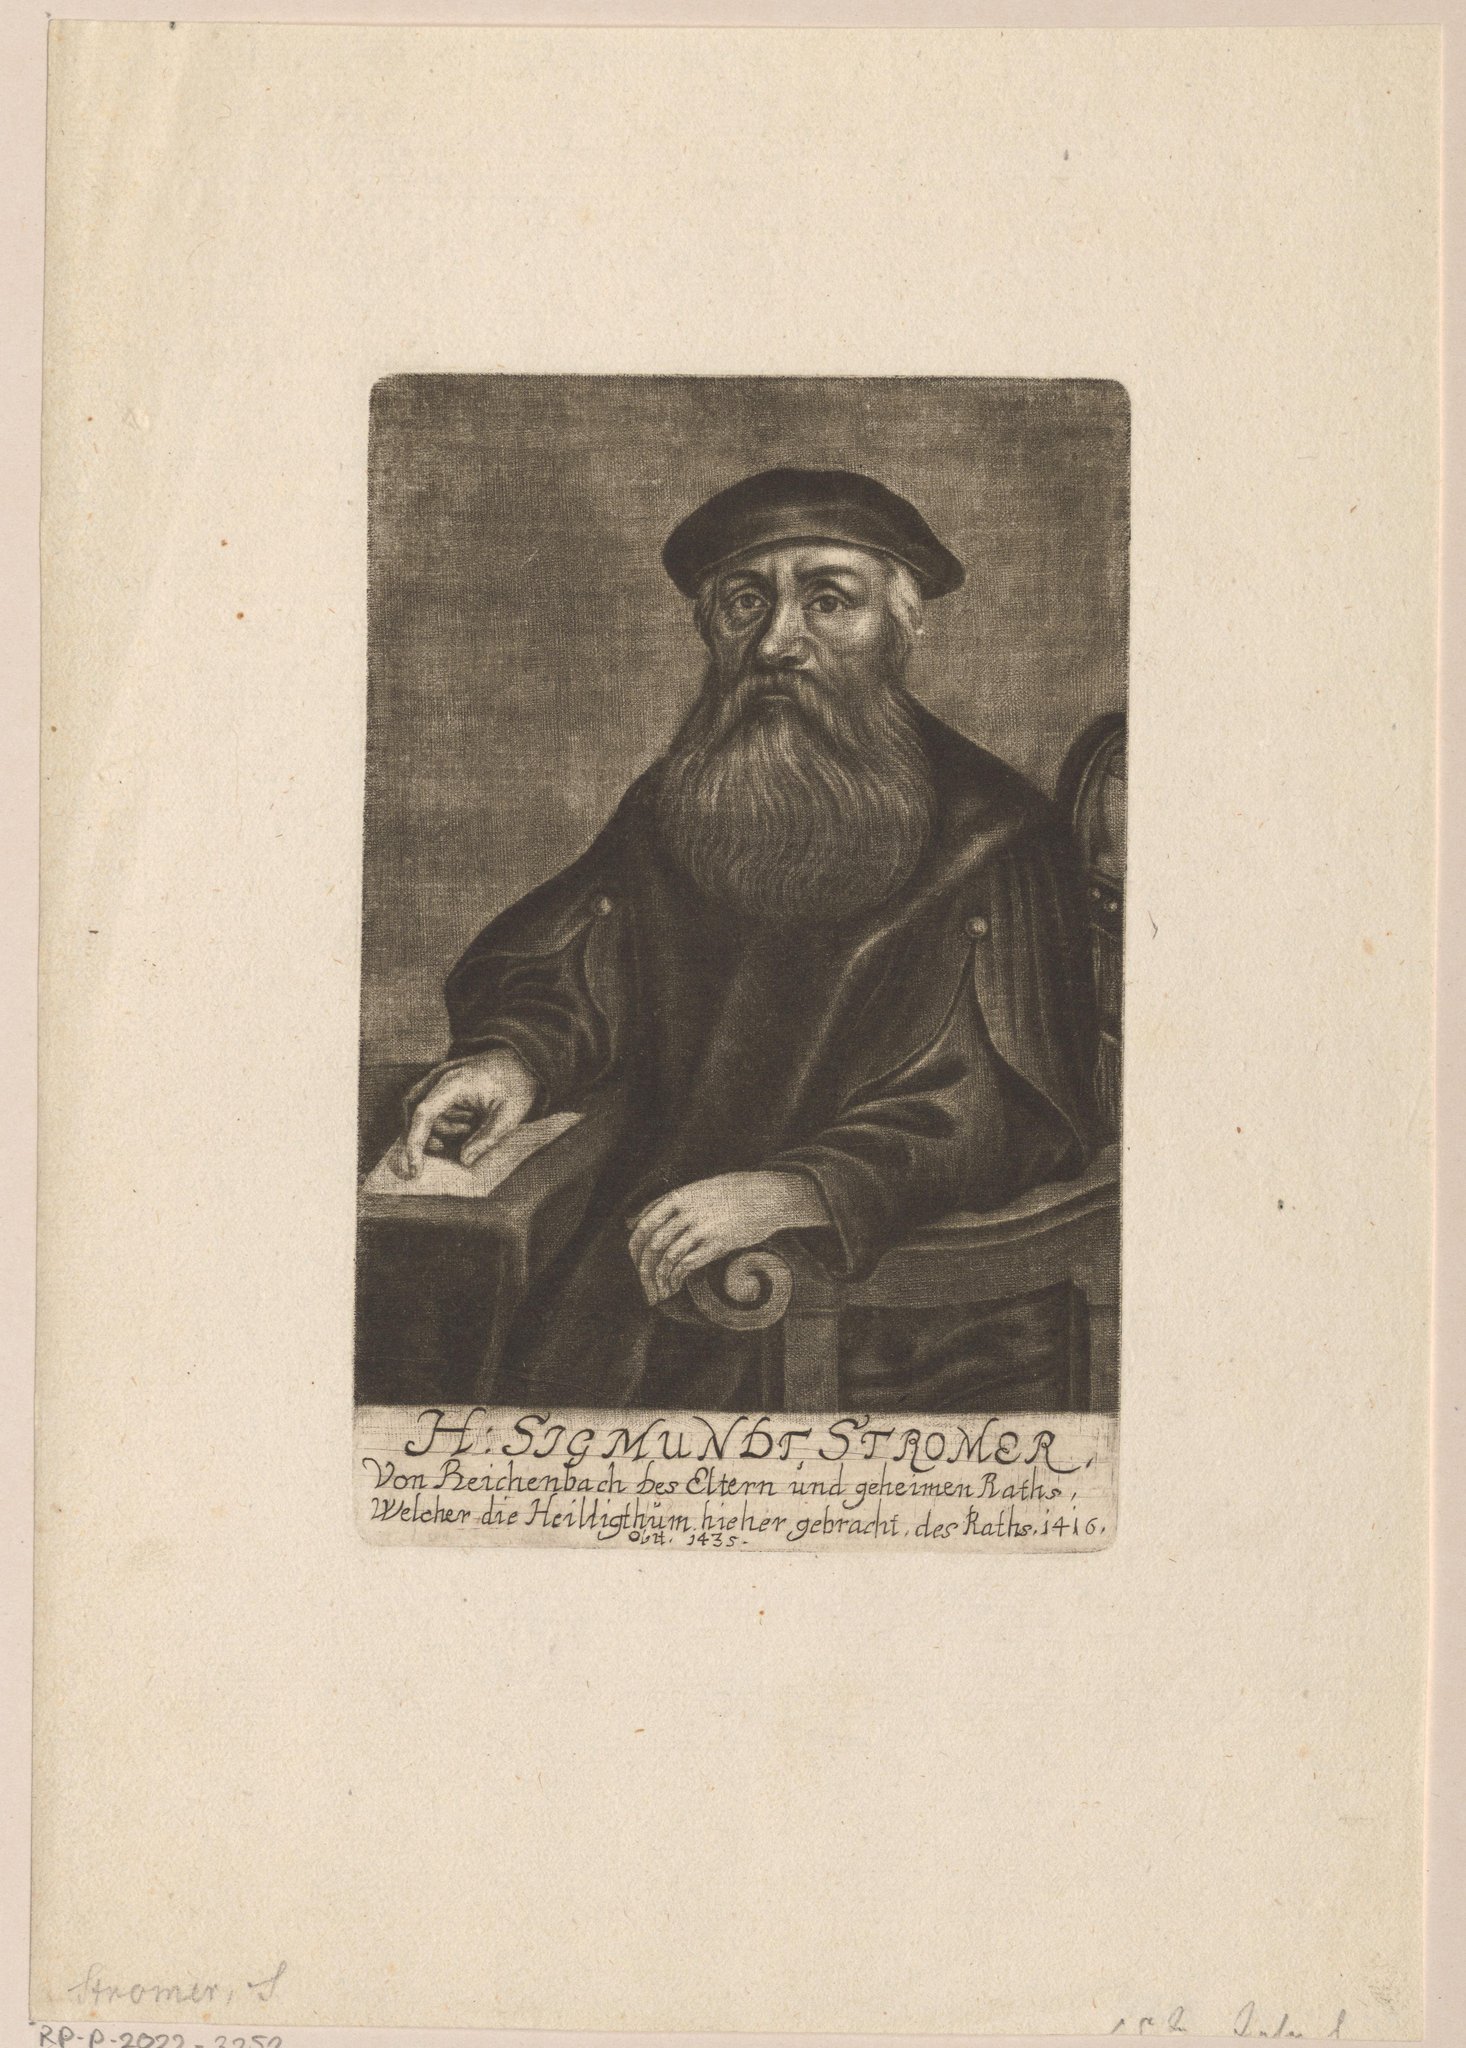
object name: print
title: Portret van Sigmund Stromer von Reichenbach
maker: georg fennitzer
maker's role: print maker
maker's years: 1646-1722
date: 1656-1722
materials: paper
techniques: mezzotint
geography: germany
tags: historical persons, counsellor